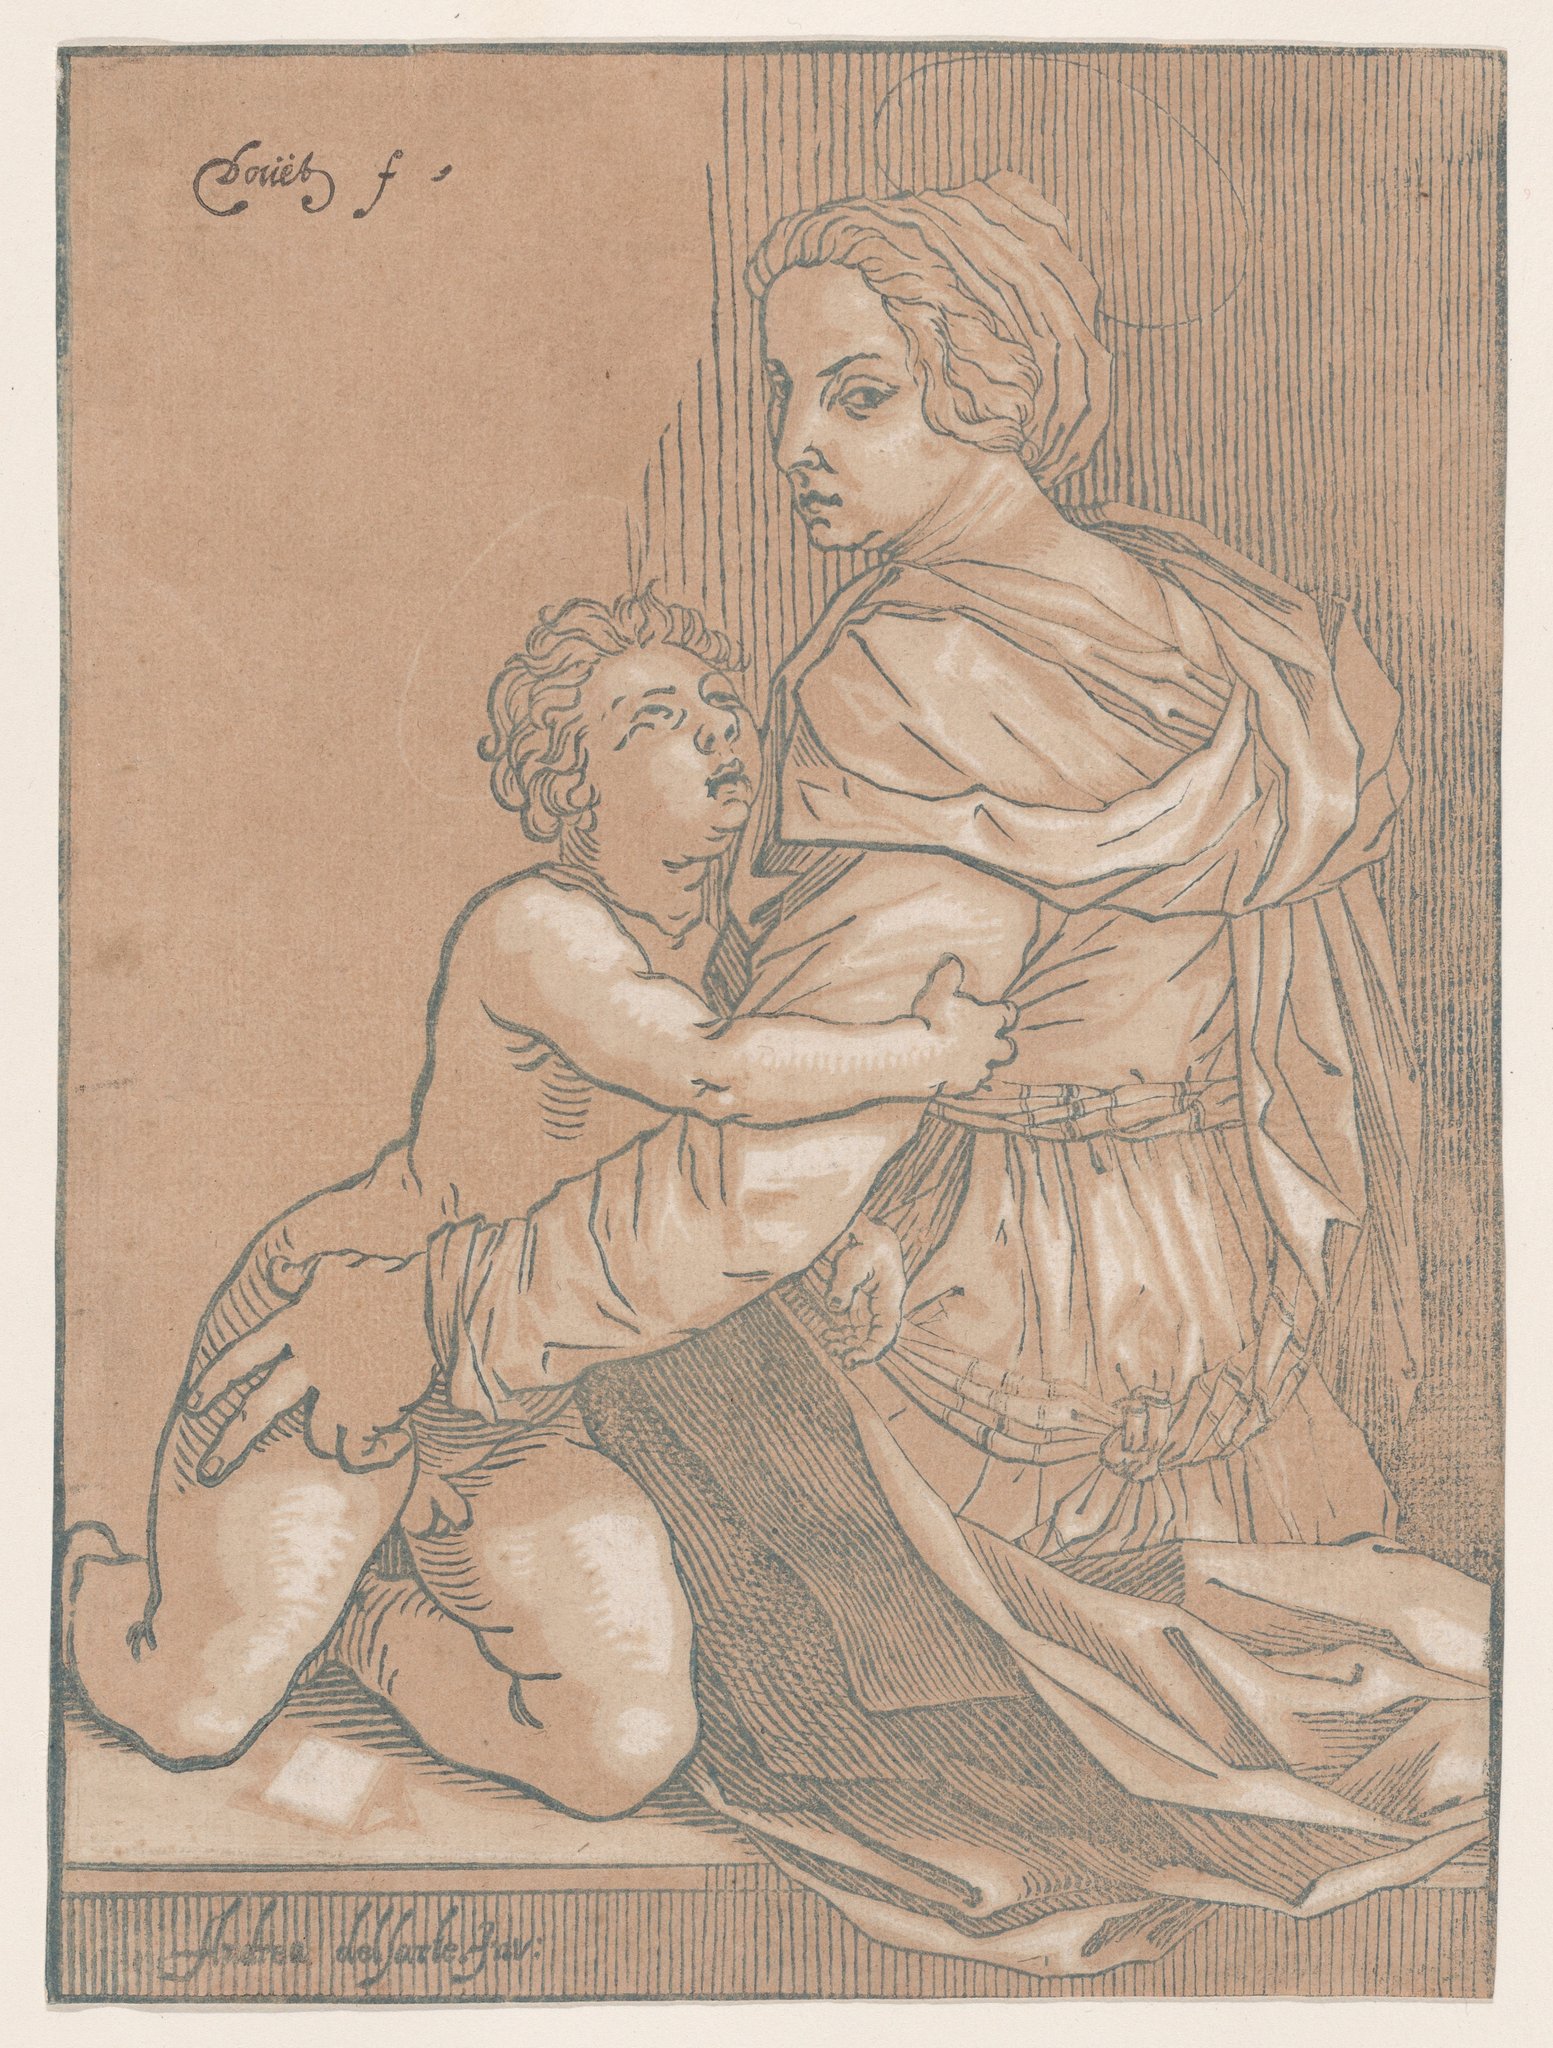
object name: print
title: Virgin and child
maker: edmond douet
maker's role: artist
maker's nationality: french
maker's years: 1480-1580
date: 1530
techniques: woodcut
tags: madonna and child